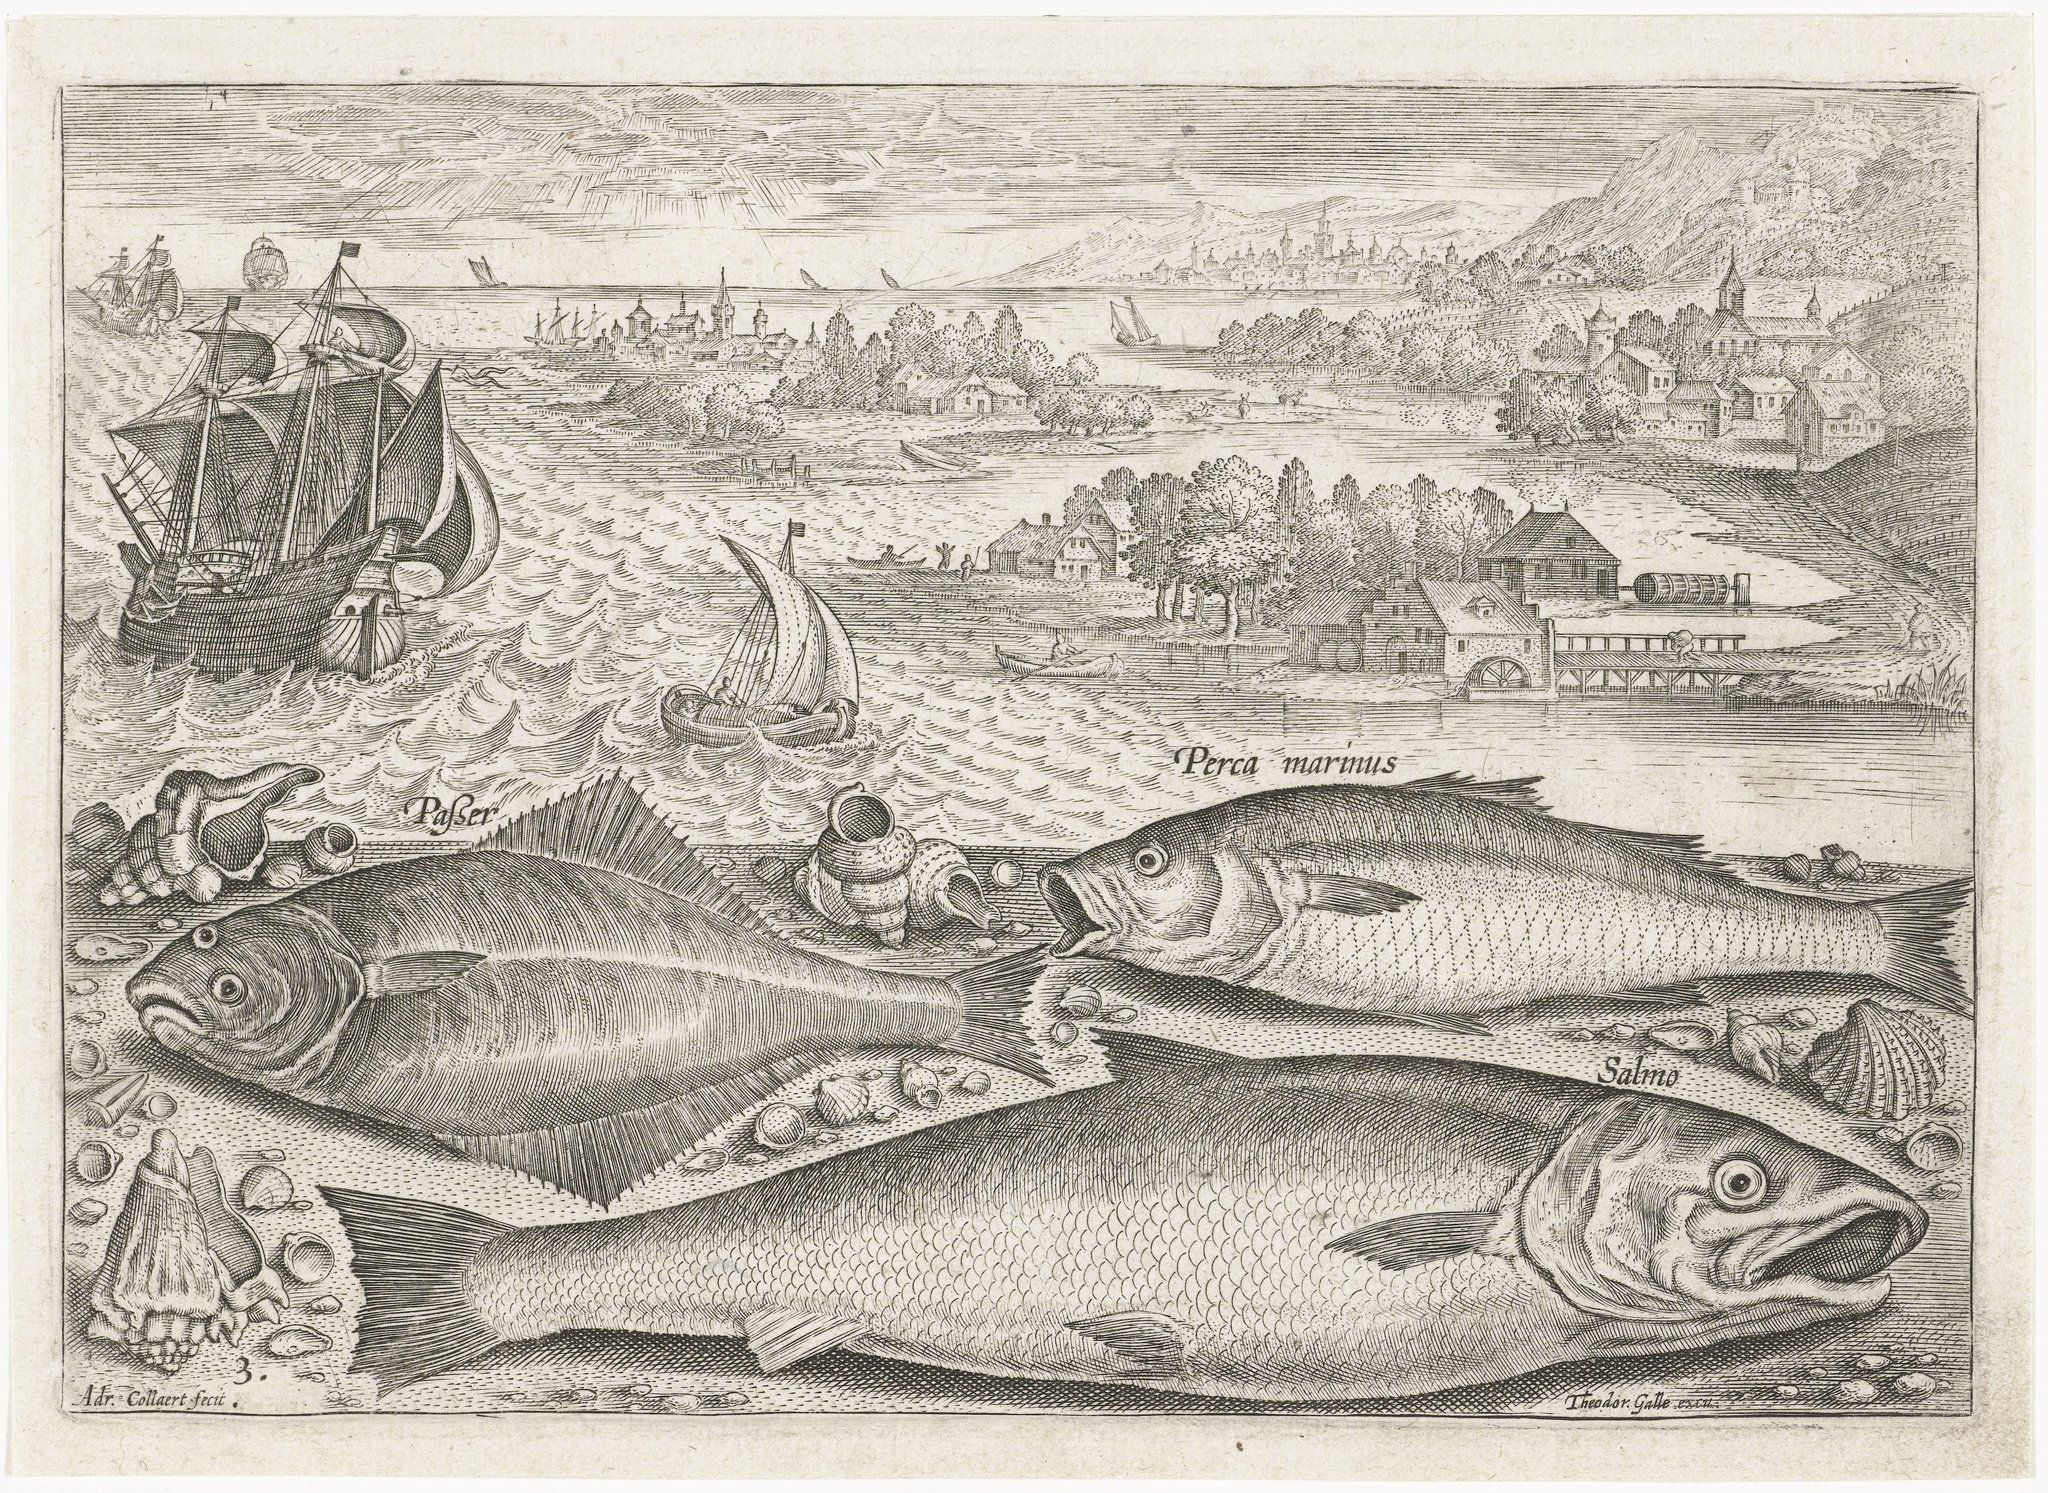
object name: print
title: Drie vissen op het strand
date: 1627-1636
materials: paper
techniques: engraving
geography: antwerp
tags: bony fishes: salmon, sea (seascape), bony fishes: sole, bony fishes: seabass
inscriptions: collector's mark: Lugt 2228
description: Een tong, een zalm en een zeebaars liggen samen met wat schelpen aangespoeld op het strand. Op de achtergrond de zee en wat schepen. De prent maakt deel uit van een serie met vissen als onderwerp.